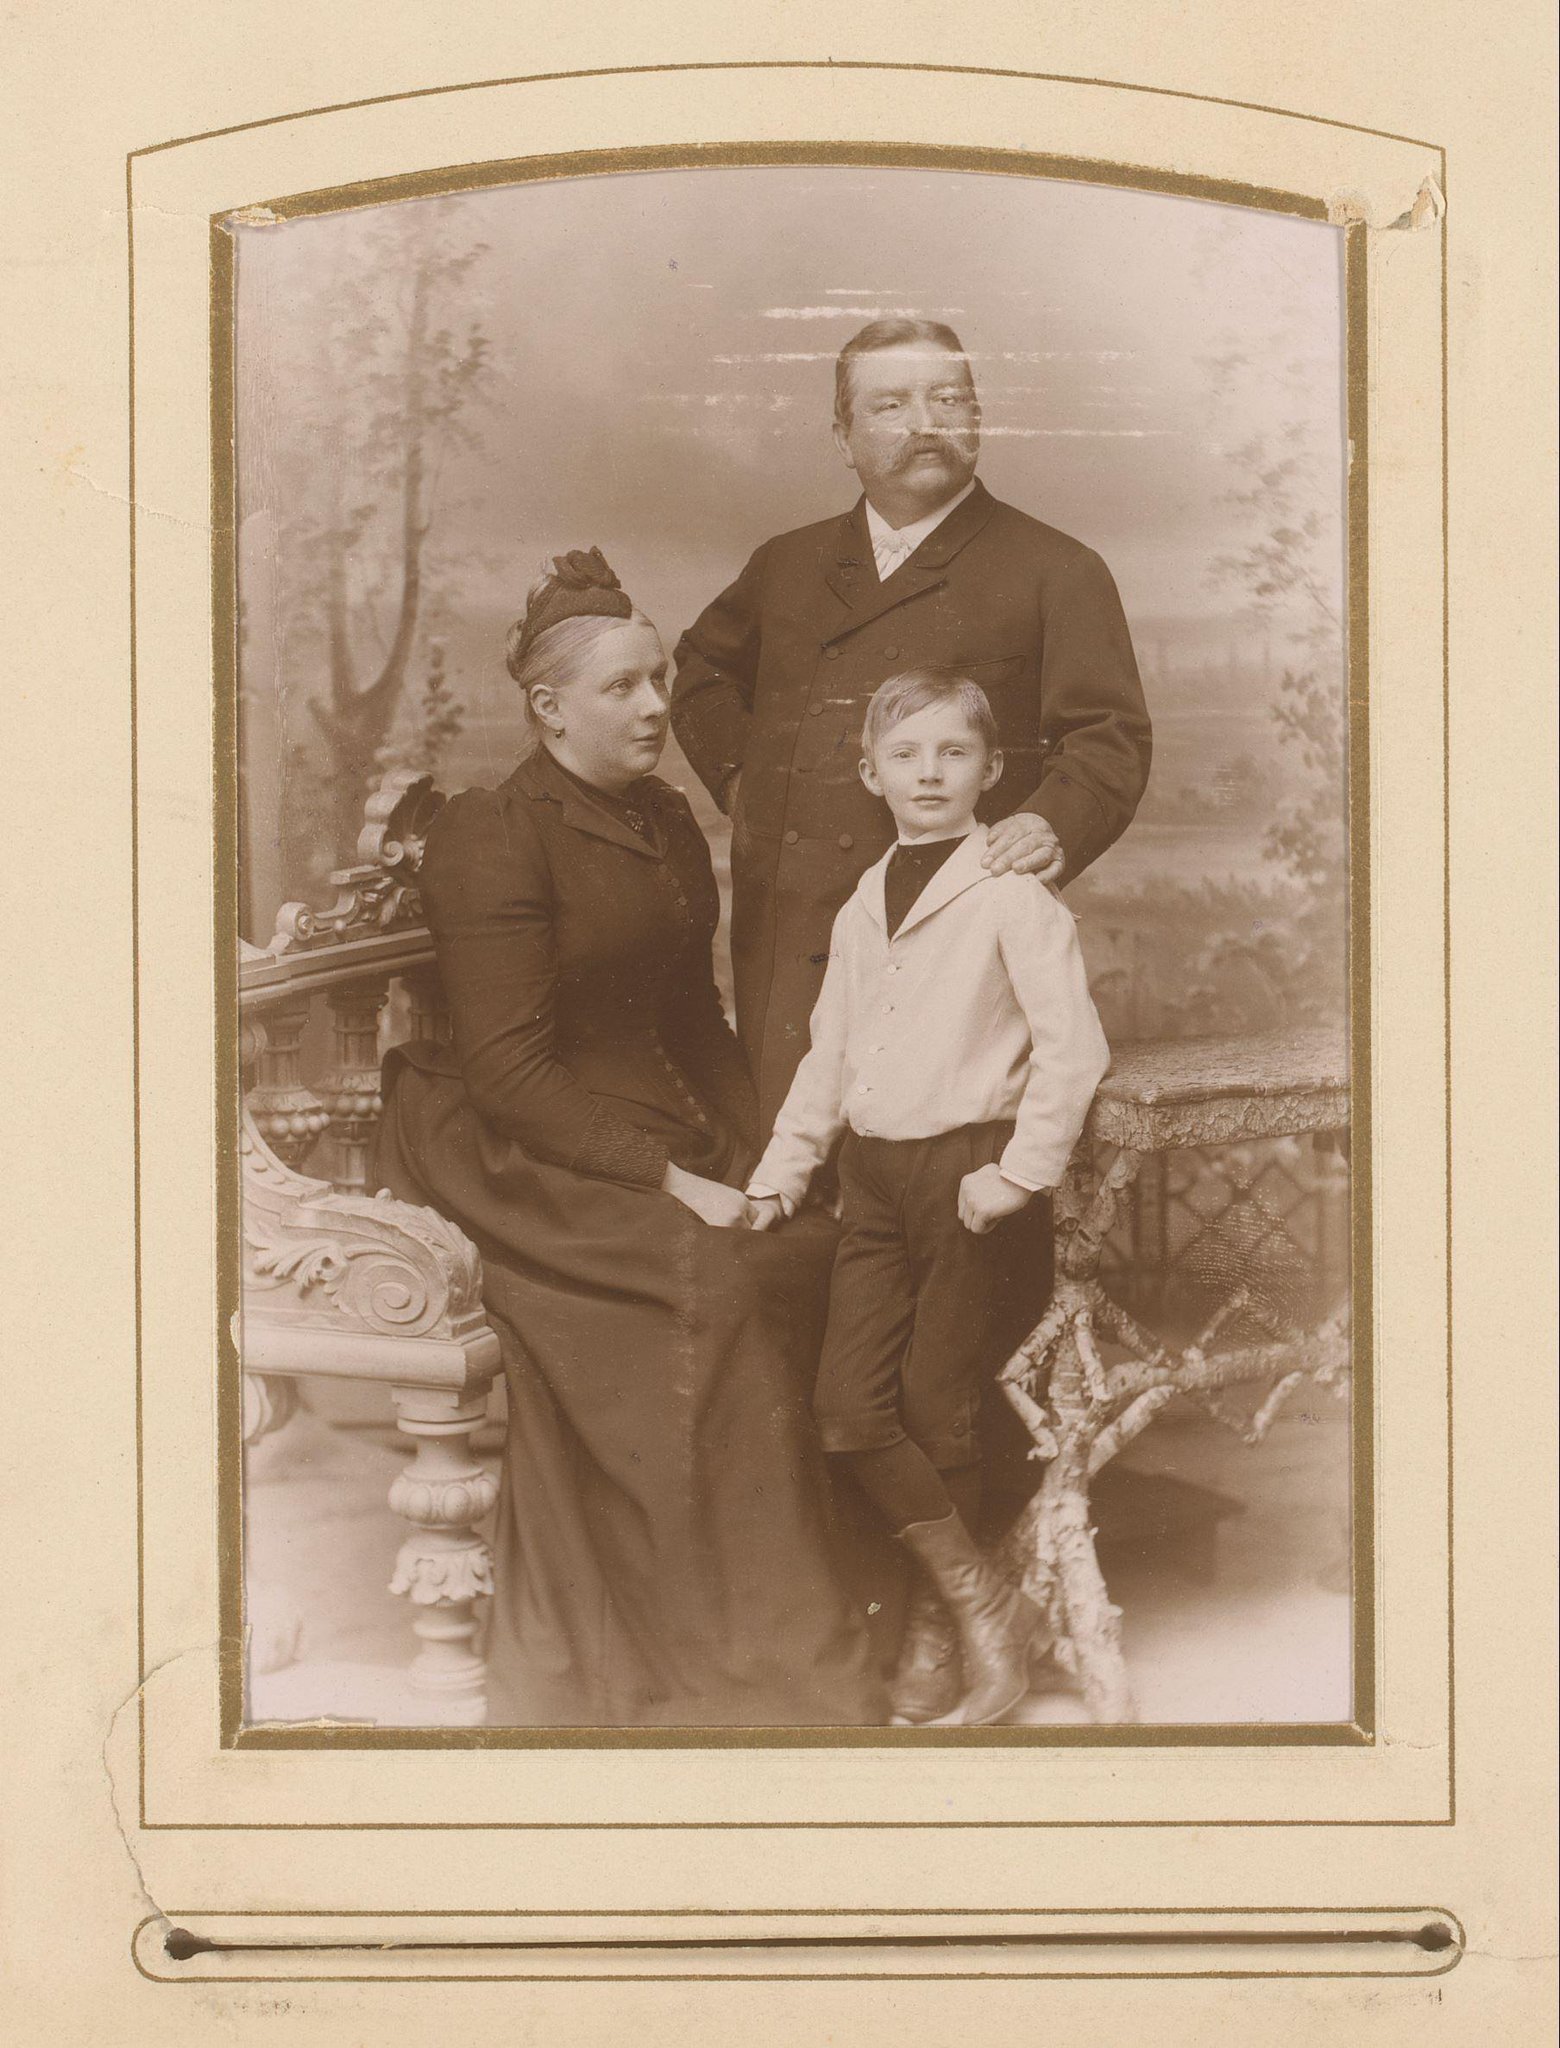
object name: album leaf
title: Portret van een man, een vrouw en een jongen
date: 1893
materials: cardboard, photographic support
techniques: collodion silver print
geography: erfurt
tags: adult woman, boy (child between toddler and youth), adult man, anonymous historical persons portrayed in a group, in a group-portrait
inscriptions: number: ‘1093’, inscription: ‘Photographisch/ Artis. Atelier/ Bissinger & Dittmann/ Inhaber: E. Bissinger./ Anger 25/ Erfurt./ Die Platten bleiben für Nachbestellungen aufbewahrt/ und können jederzeit Abzüge sowie Vergrösserungen/ davon geliefert werden.’, annotation: ‘zur freundlichen Erinnerung!/ Erfurt 25 Mai 1893.’